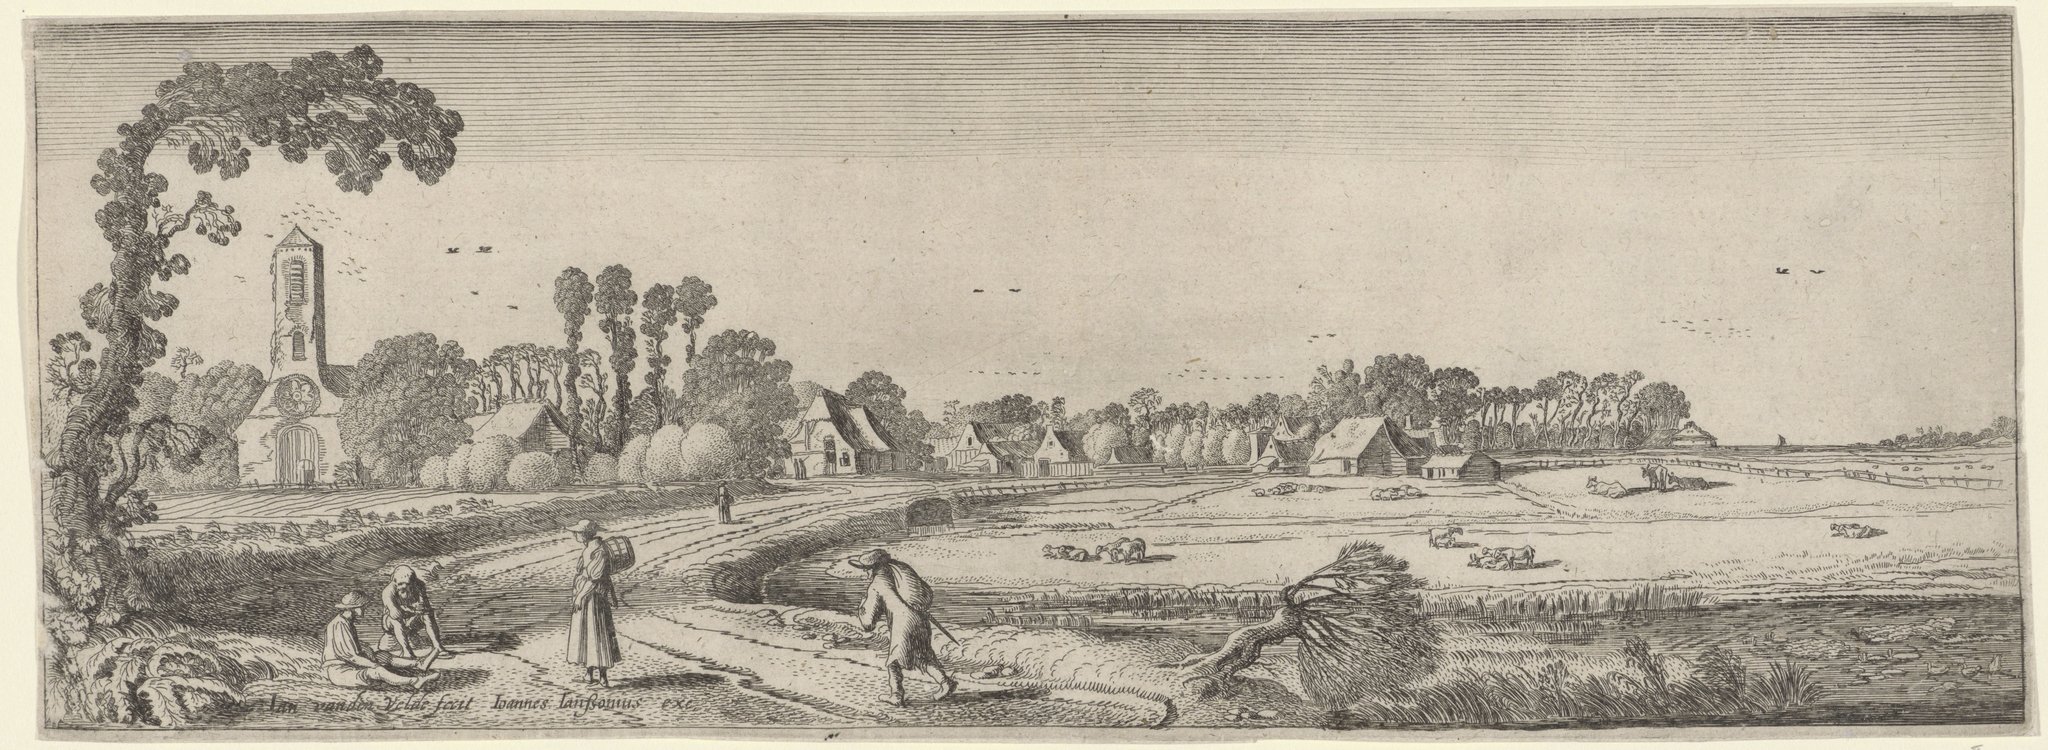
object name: print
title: Landschappen van oblong formaat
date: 1608-1665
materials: paper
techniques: etching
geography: northern netherlands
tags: prospect of village, silhouette of village, meadow, pasture, church (exterior), road, path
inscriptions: collector's mark: Lugt 240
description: Figuren op een pad naar een dorp in een weidelandschap. Links een kerk. Prent uit een serie van acht.